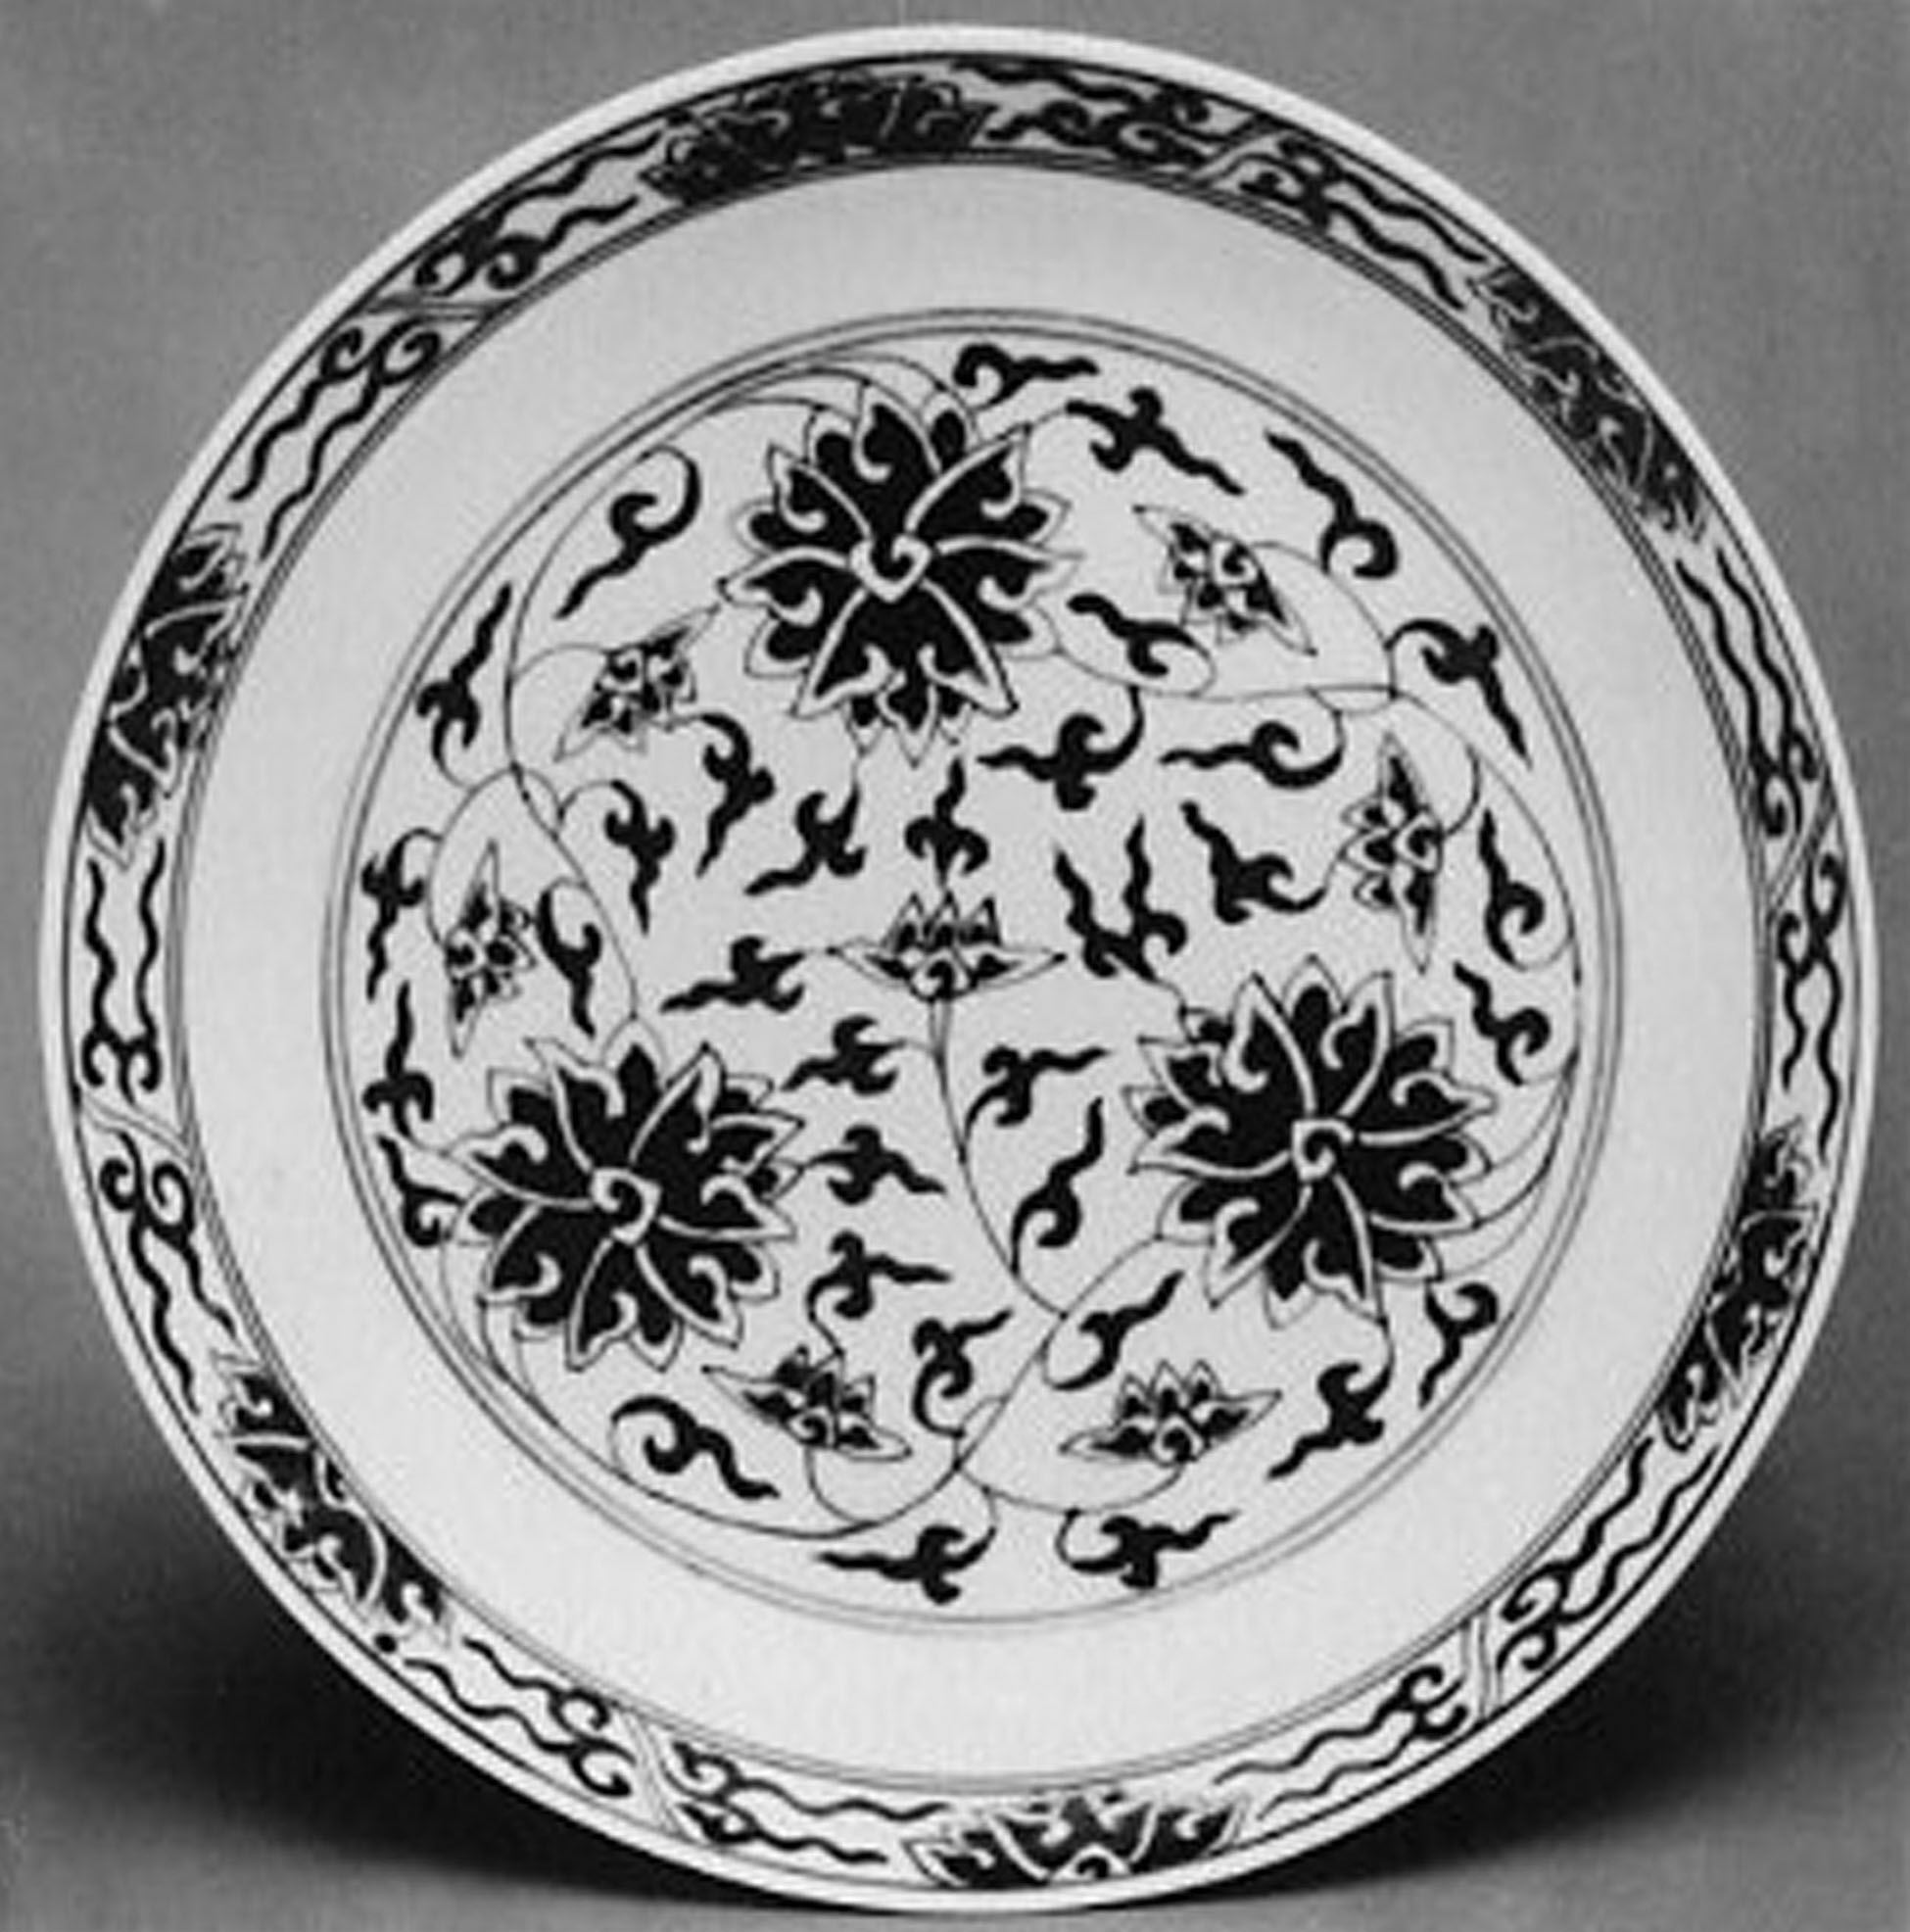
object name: dish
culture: chinese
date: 1875-1908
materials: porcelain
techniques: underglaze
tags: flowers